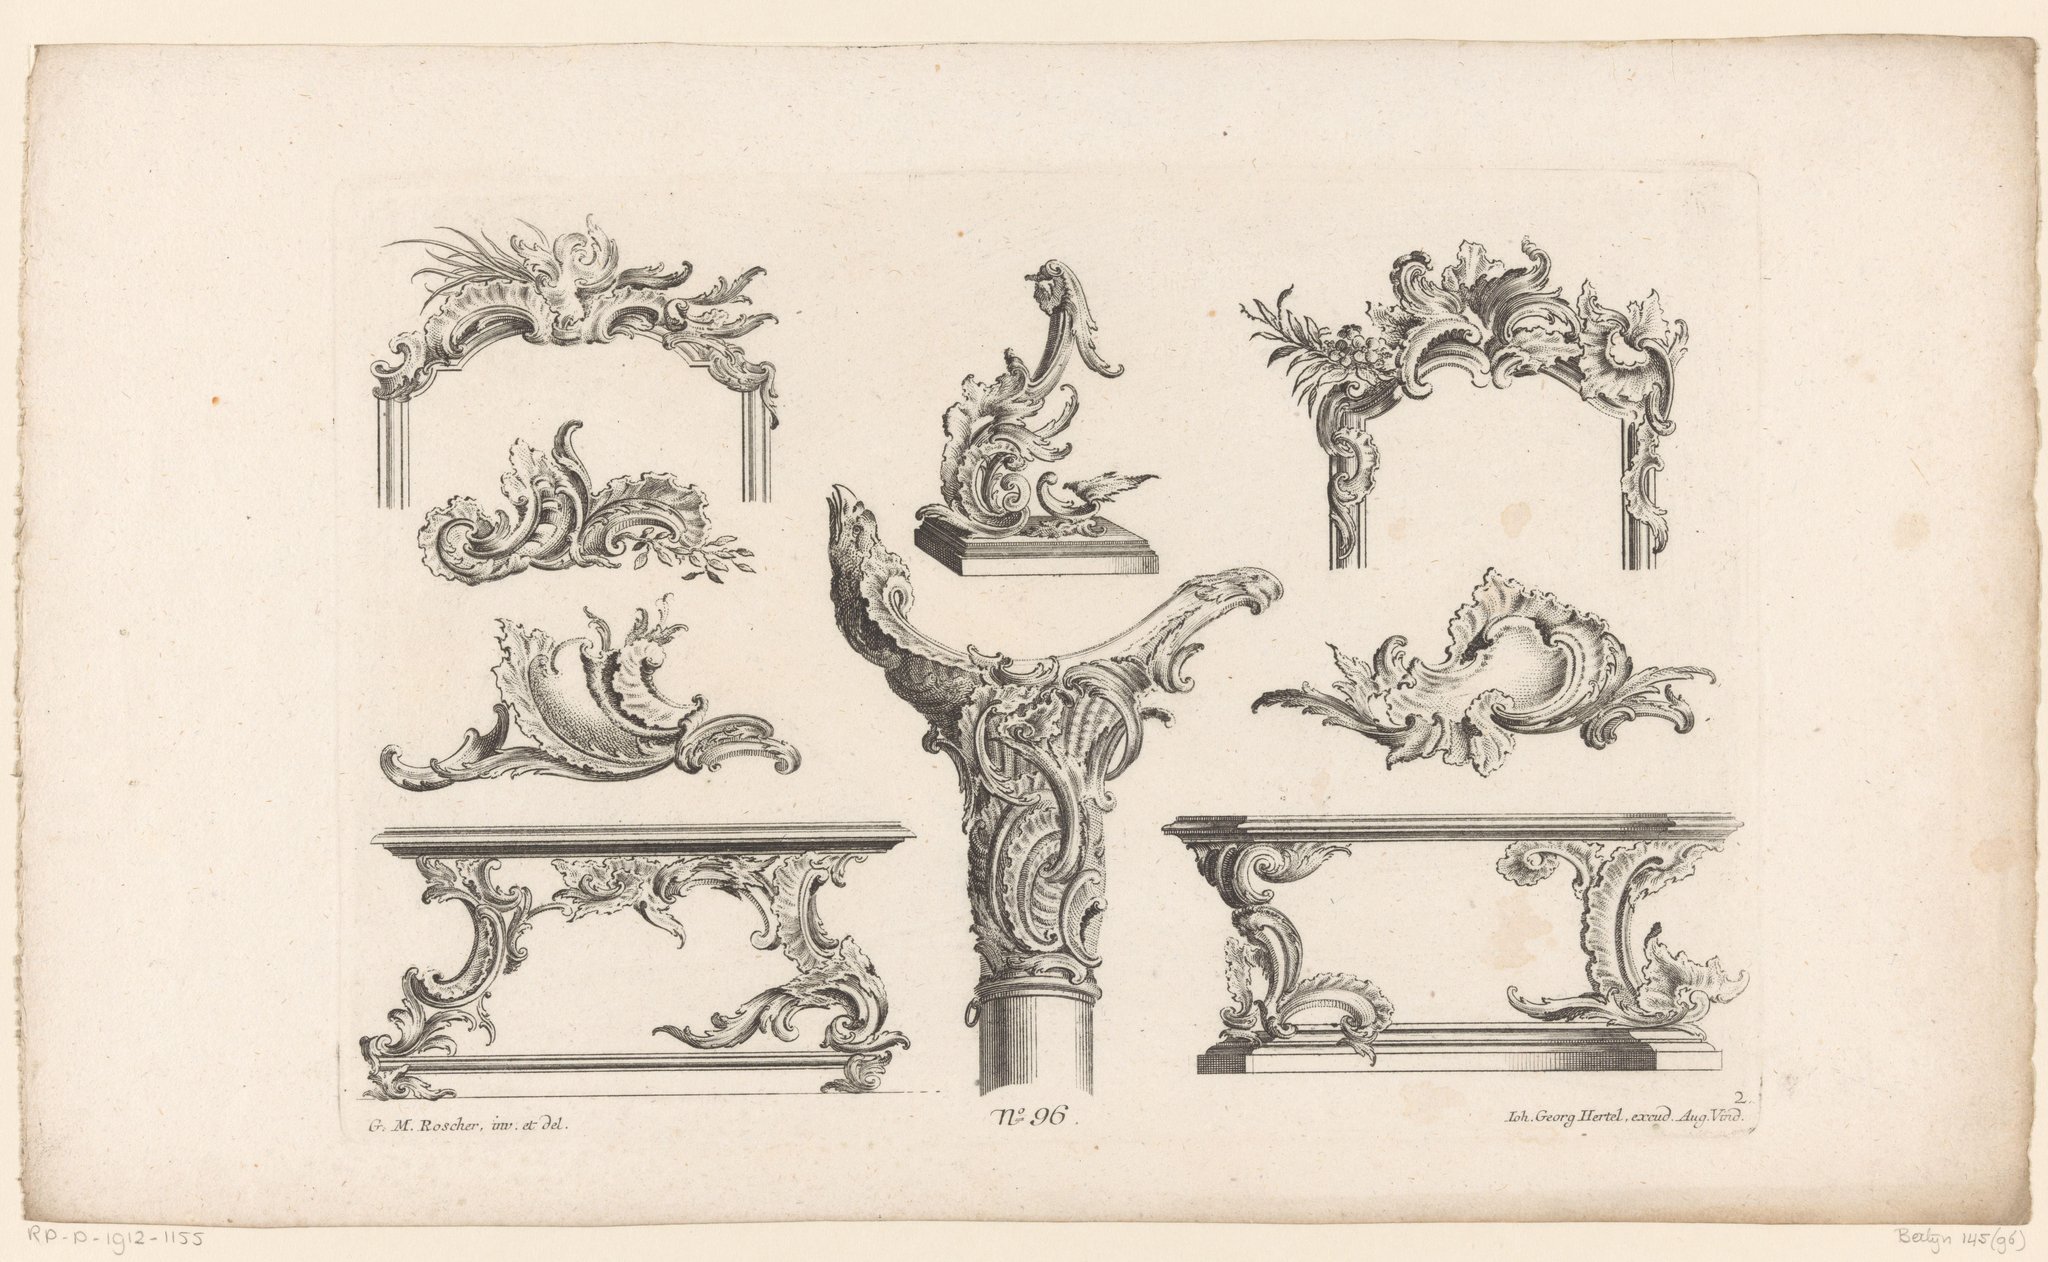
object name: print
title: Rocaille motieven met stokknop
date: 1727-1775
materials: paper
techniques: etching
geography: augsburg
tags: rocaille ornament, ornaments ~ art (+ framing decorations), table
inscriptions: collector's mark: Lugt 2228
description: Rocaille ornamenten, twee tafels met rocaille onderstel, twee details van rocaille spiegellijsten en een geornamenteerde stokknop. Uitgeversnummer 96.